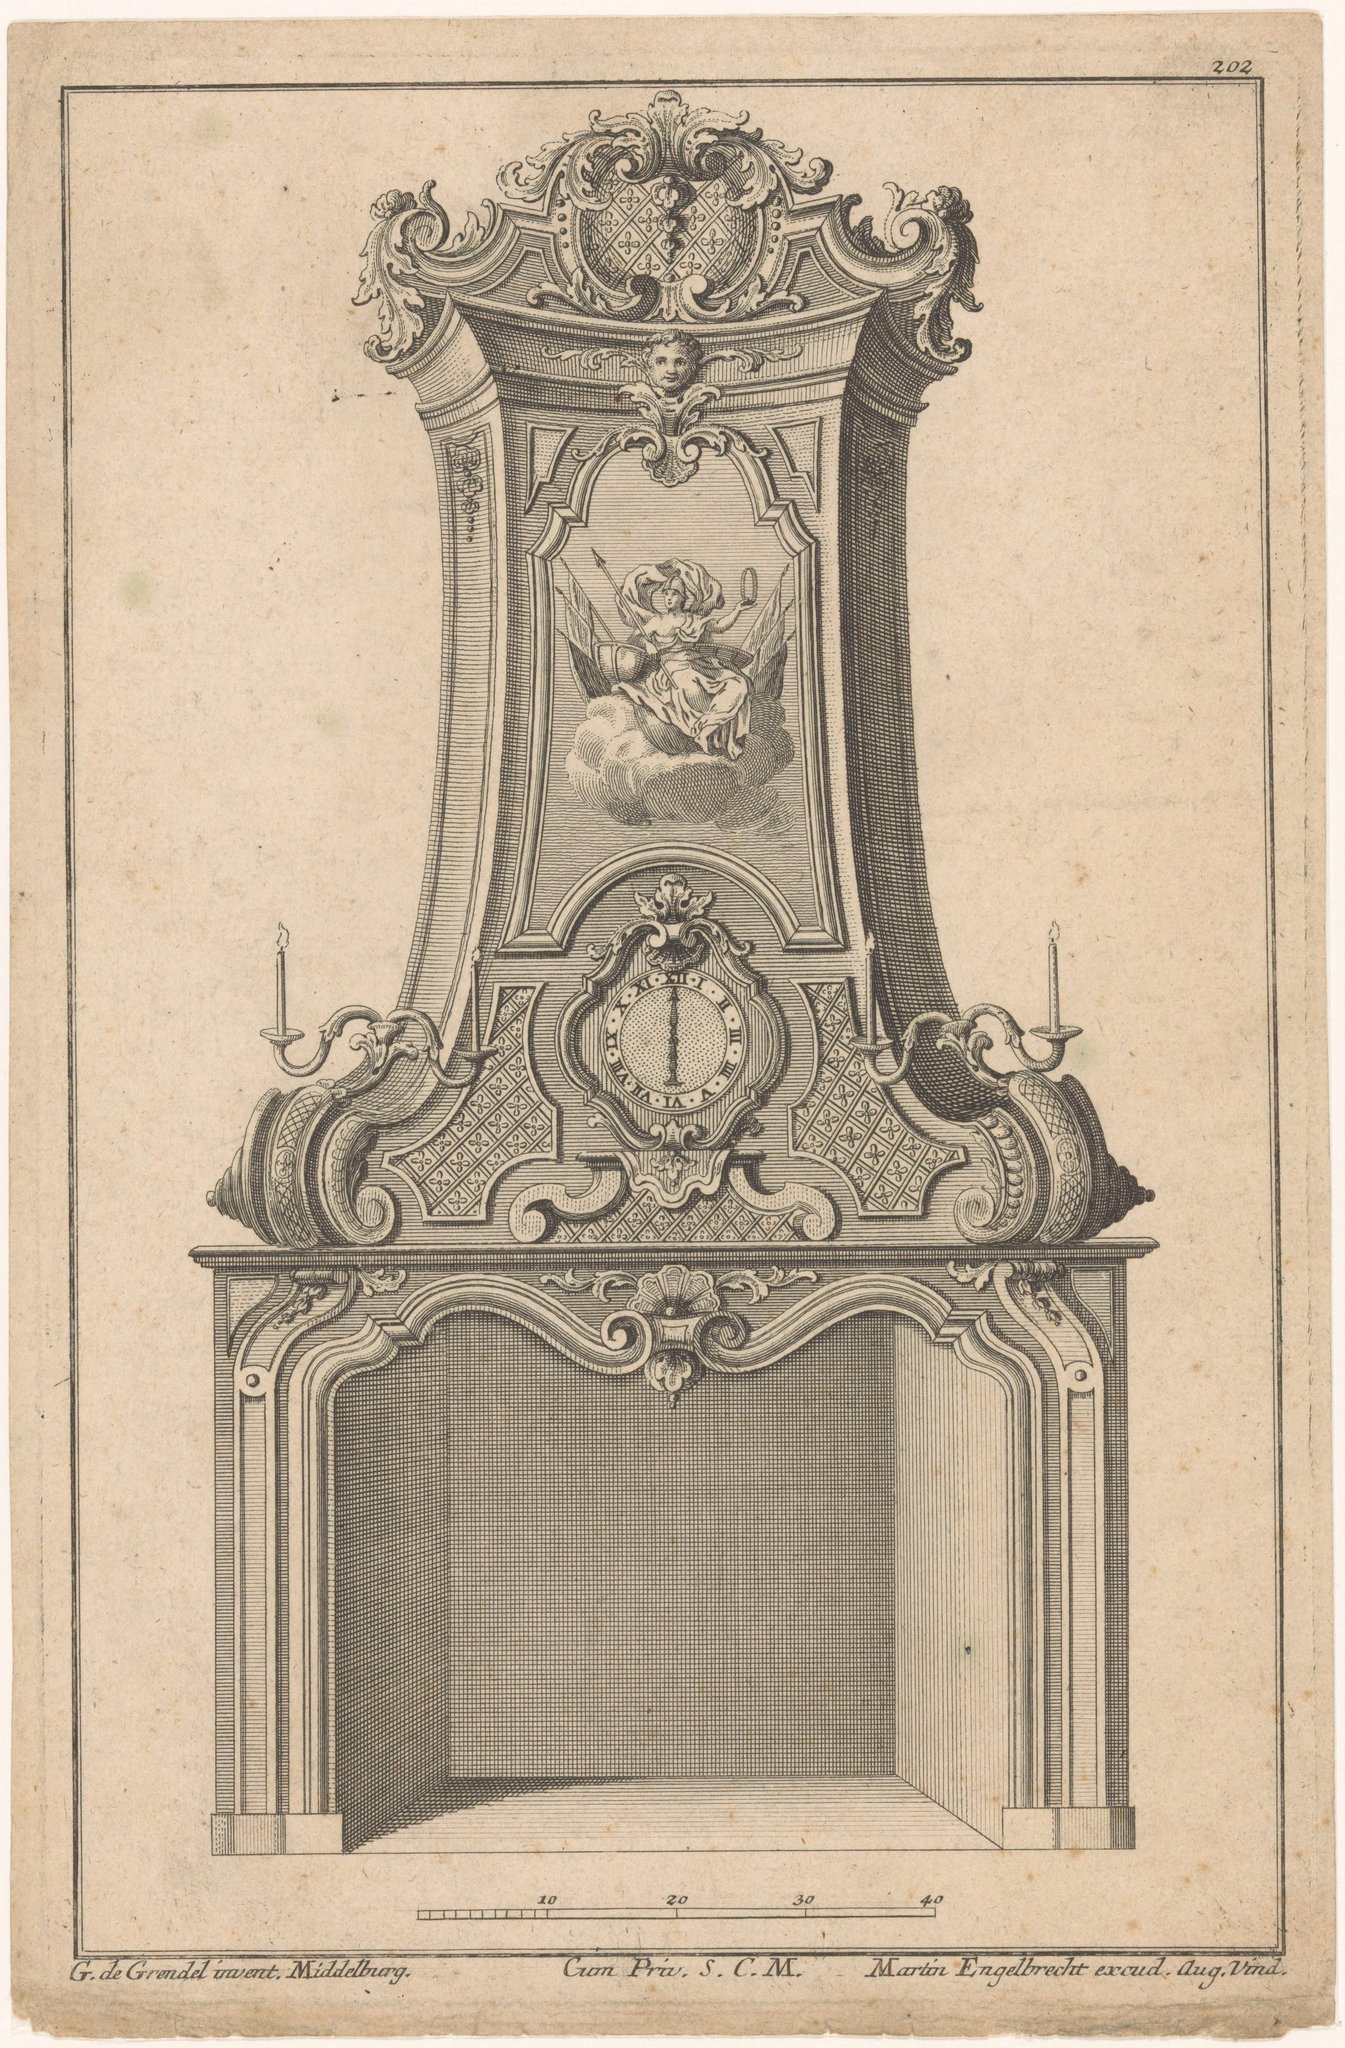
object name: print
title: Ontwerp voor een schoorsteen met Minerva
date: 1708-1756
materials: paper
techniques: engraving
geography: augsburg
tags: chimney, ornaments ~ art, (story of) minerva (pallas, athena), clock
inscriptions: collector's mark: Lugt 2228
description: Ontwerp voor een schoorsteen met een voorstelling van Minerva, tronend op een wolk, omringd door vlaggen en met een eeuwigheidssymbool in de hand. Midden op de schoorsteenmantel een klok. Aan weerszijden kaarsen. Midden onder een schaalverdeling. Prentnummer 202.